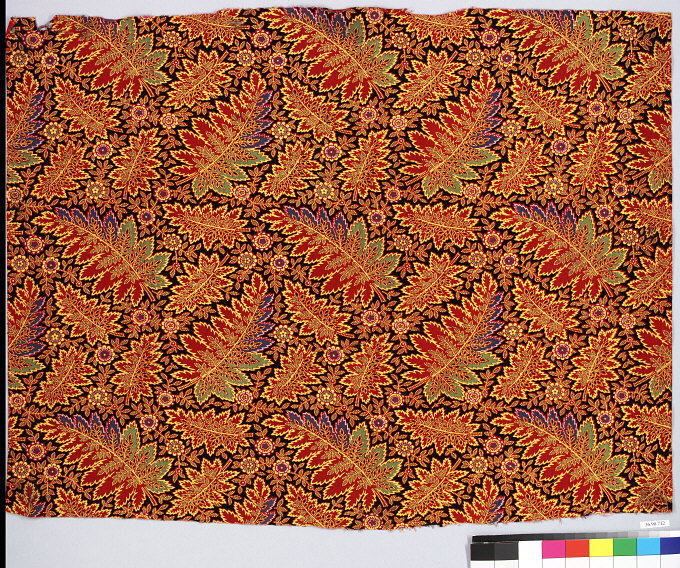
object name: piece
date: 1867-1900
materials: cotton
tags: leaves